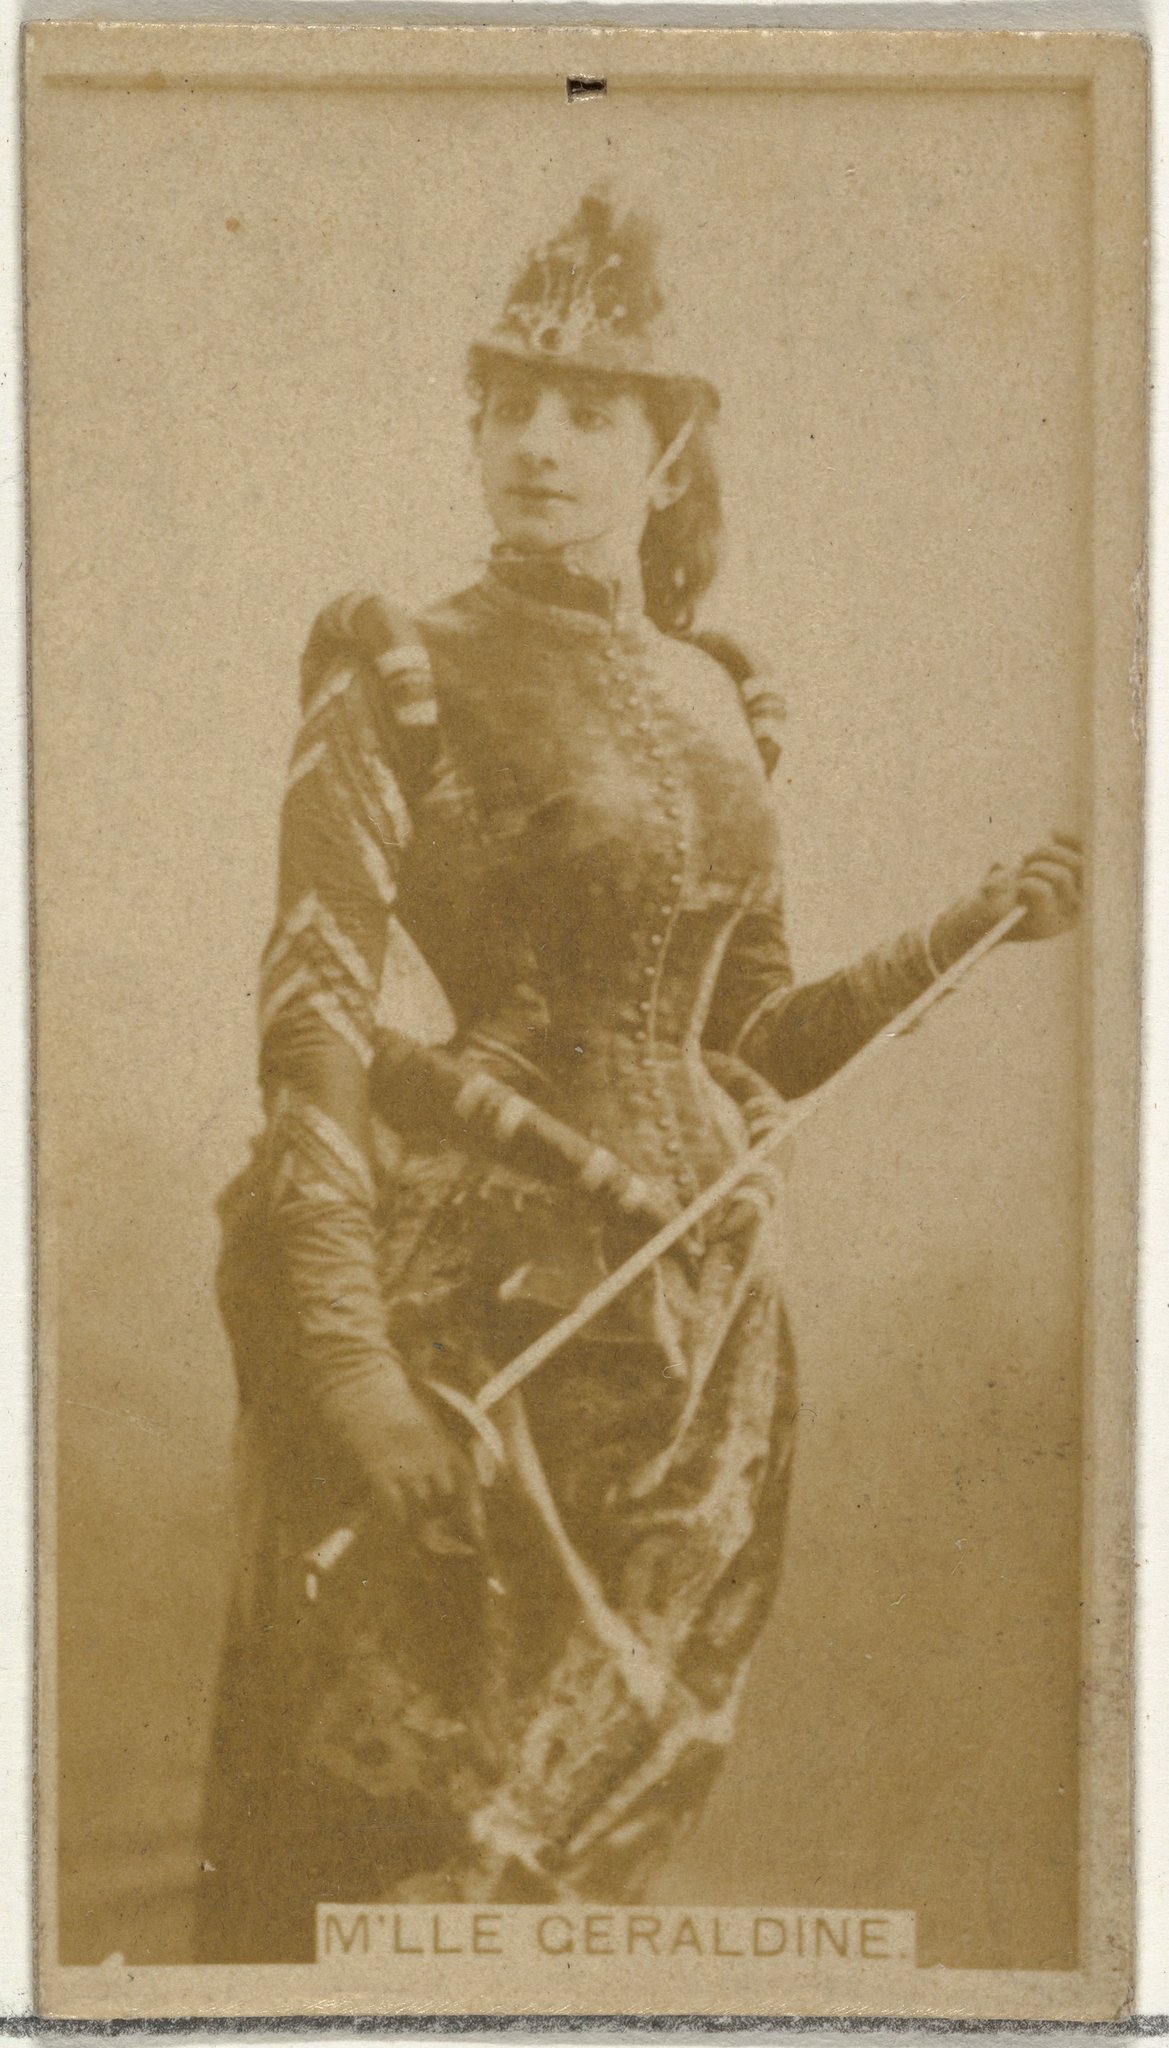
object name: photograph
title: M'lle Geraldine, from the Actors and Actresses series (N145-8) issued by Duke Sons & Co. to promote Duke Cigarettes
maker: w. duke, sons & co.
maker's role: publisher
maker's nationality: american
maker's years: 1870-1920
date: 1891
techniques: albumen silver print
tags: portraits,women,actresses